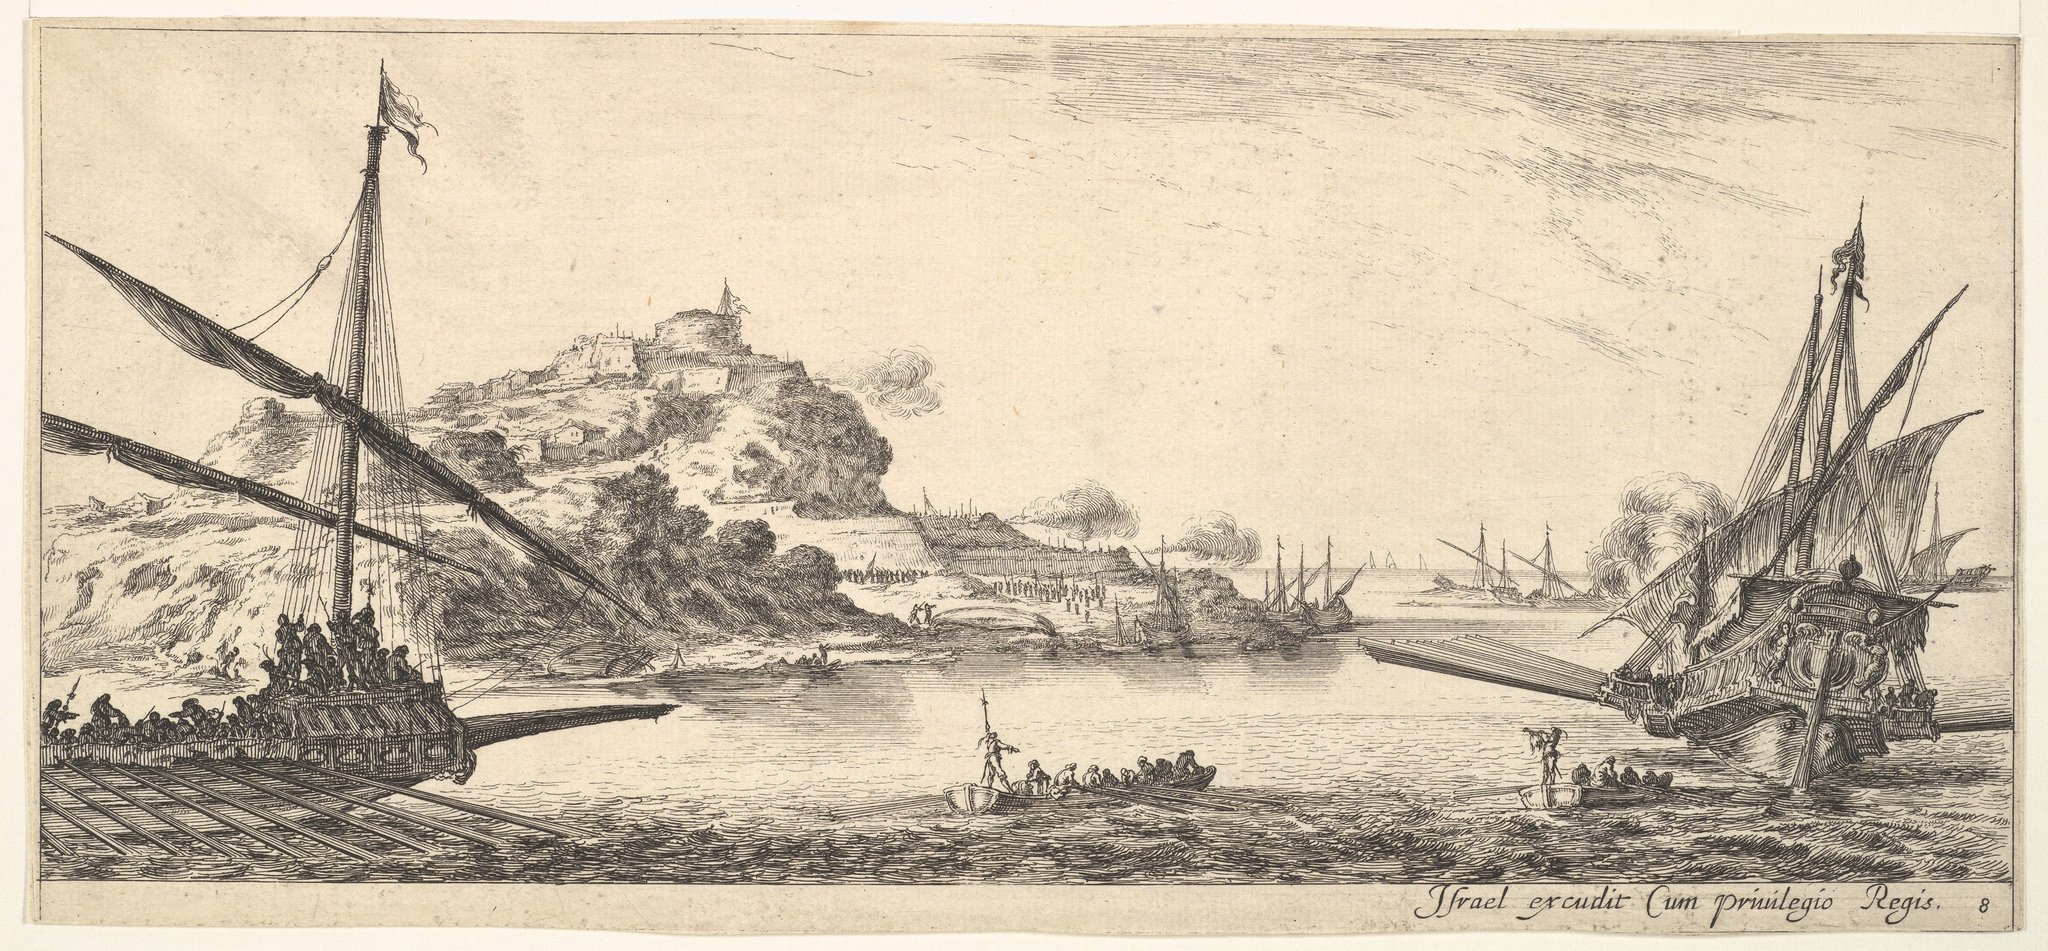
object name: print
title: Plate 8: A the bow of a galley at left and another galley at right, seen from behind, two rowboats in center, a hill with a fortress in the background, from "Various Landscapes" (Divers Paysages)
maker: stefano della bella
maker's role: artist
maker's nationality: italian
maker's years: 1610-1664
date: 1641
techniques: etching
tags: ships